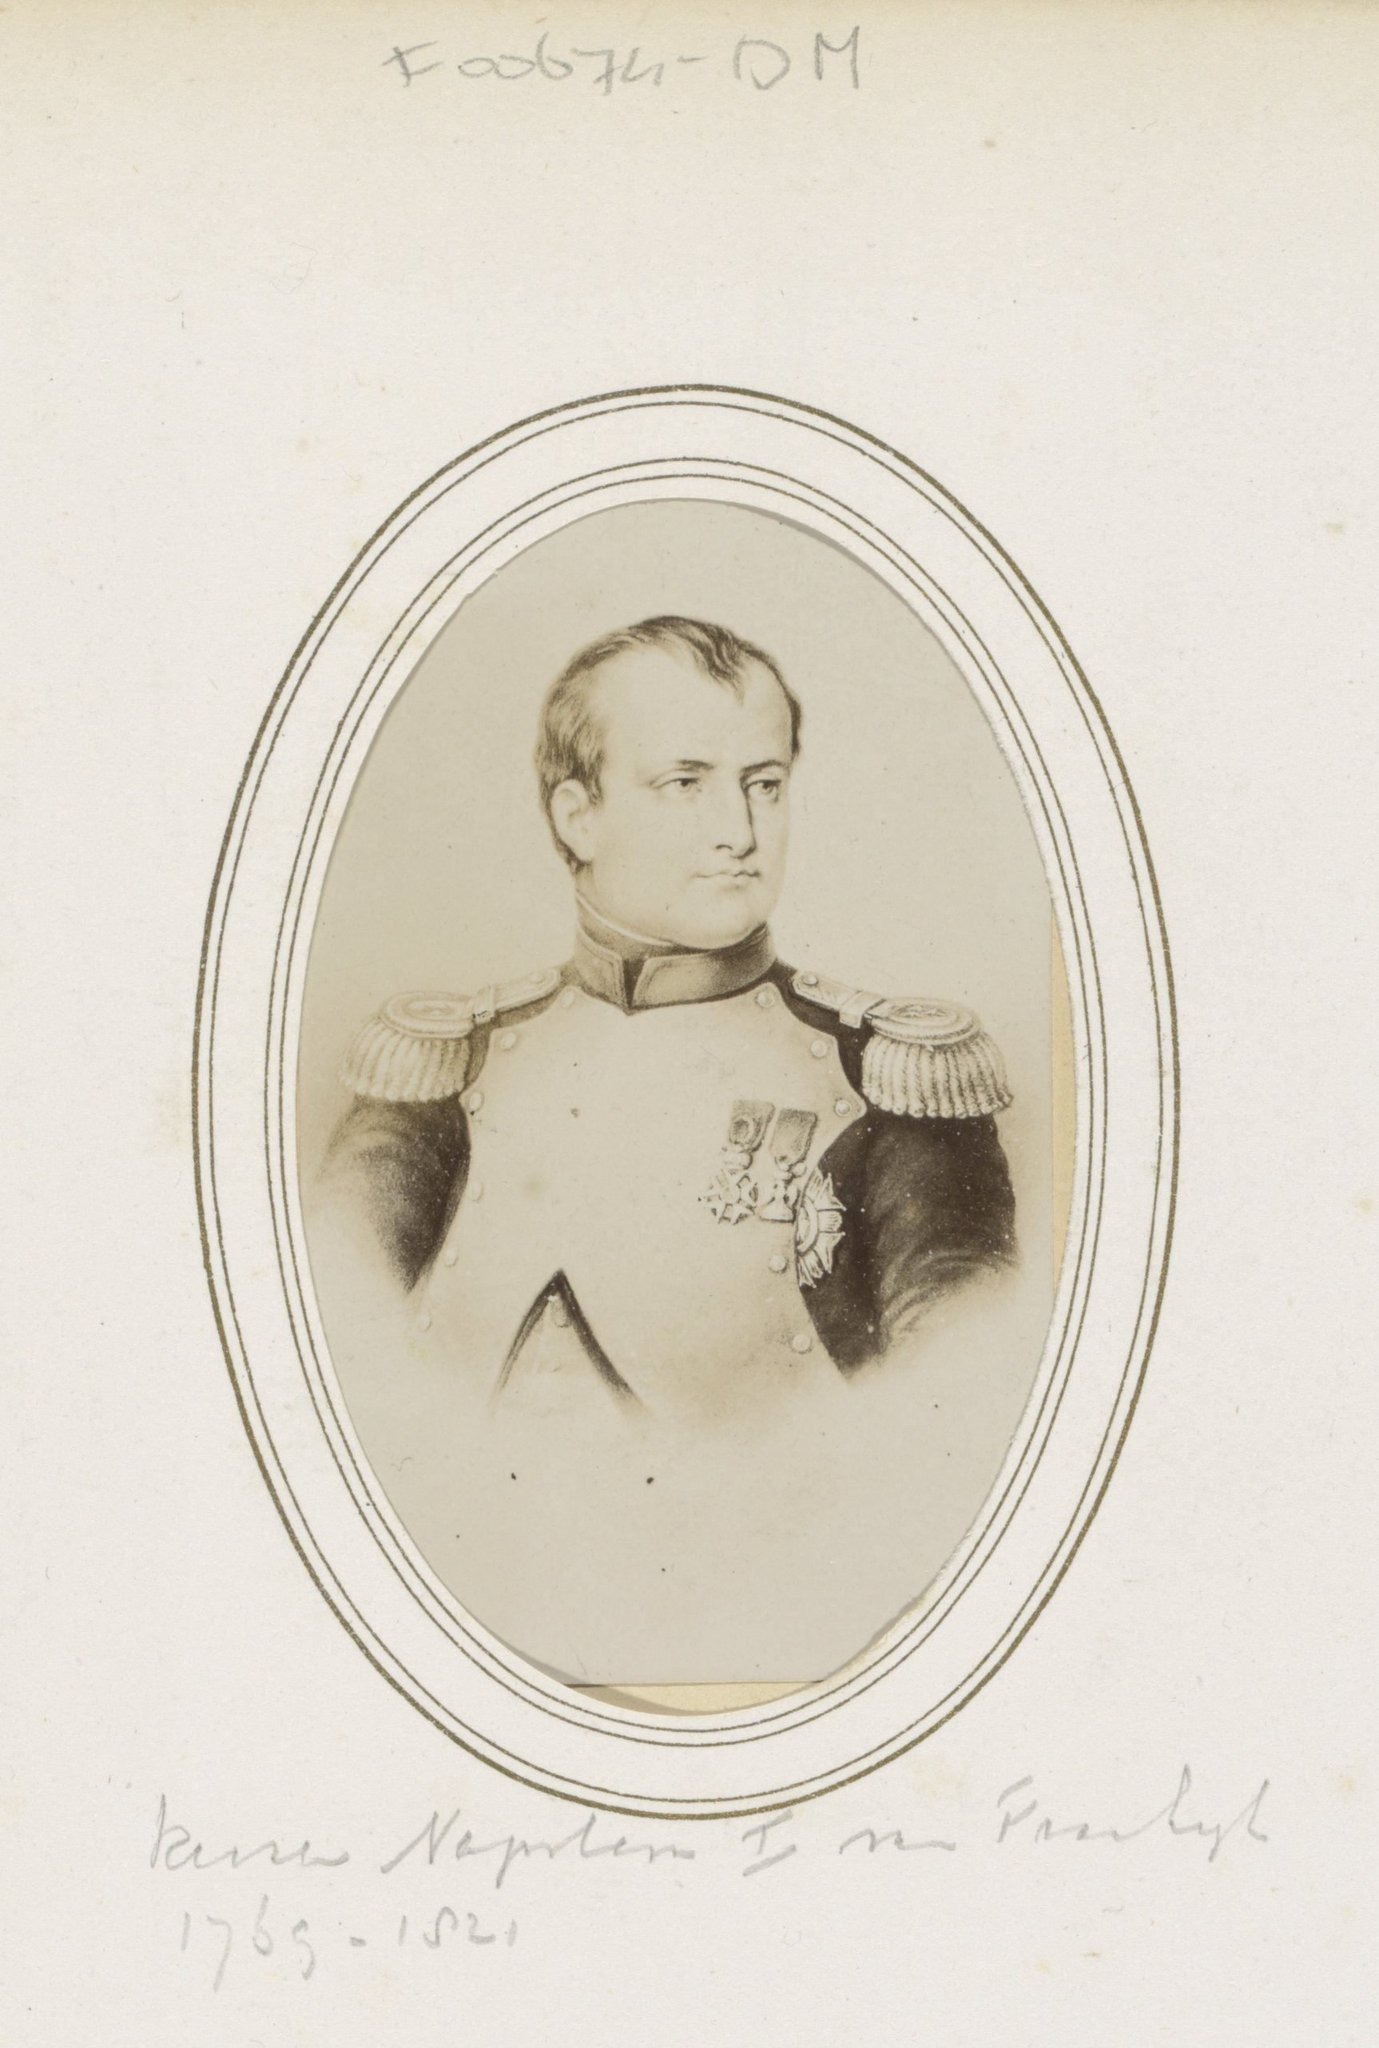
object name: reproduction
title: Fotoreproductie van (vermoedelijk) een prent van Napoleon I Bonaparte, keizer van Frankrijk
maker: Anonymous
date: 1895-1910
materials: photographic support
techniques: daylight paper print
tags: napoleon i (emperor of the french), historical persons, medals and other marks of military honour, ruler, sovereign, hairdress, (military) uniforms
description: Onderdeel van Fotoalbum met 123 cartes-de-visite van leden van Europese vorstenhuizen, politici en bekende personen.